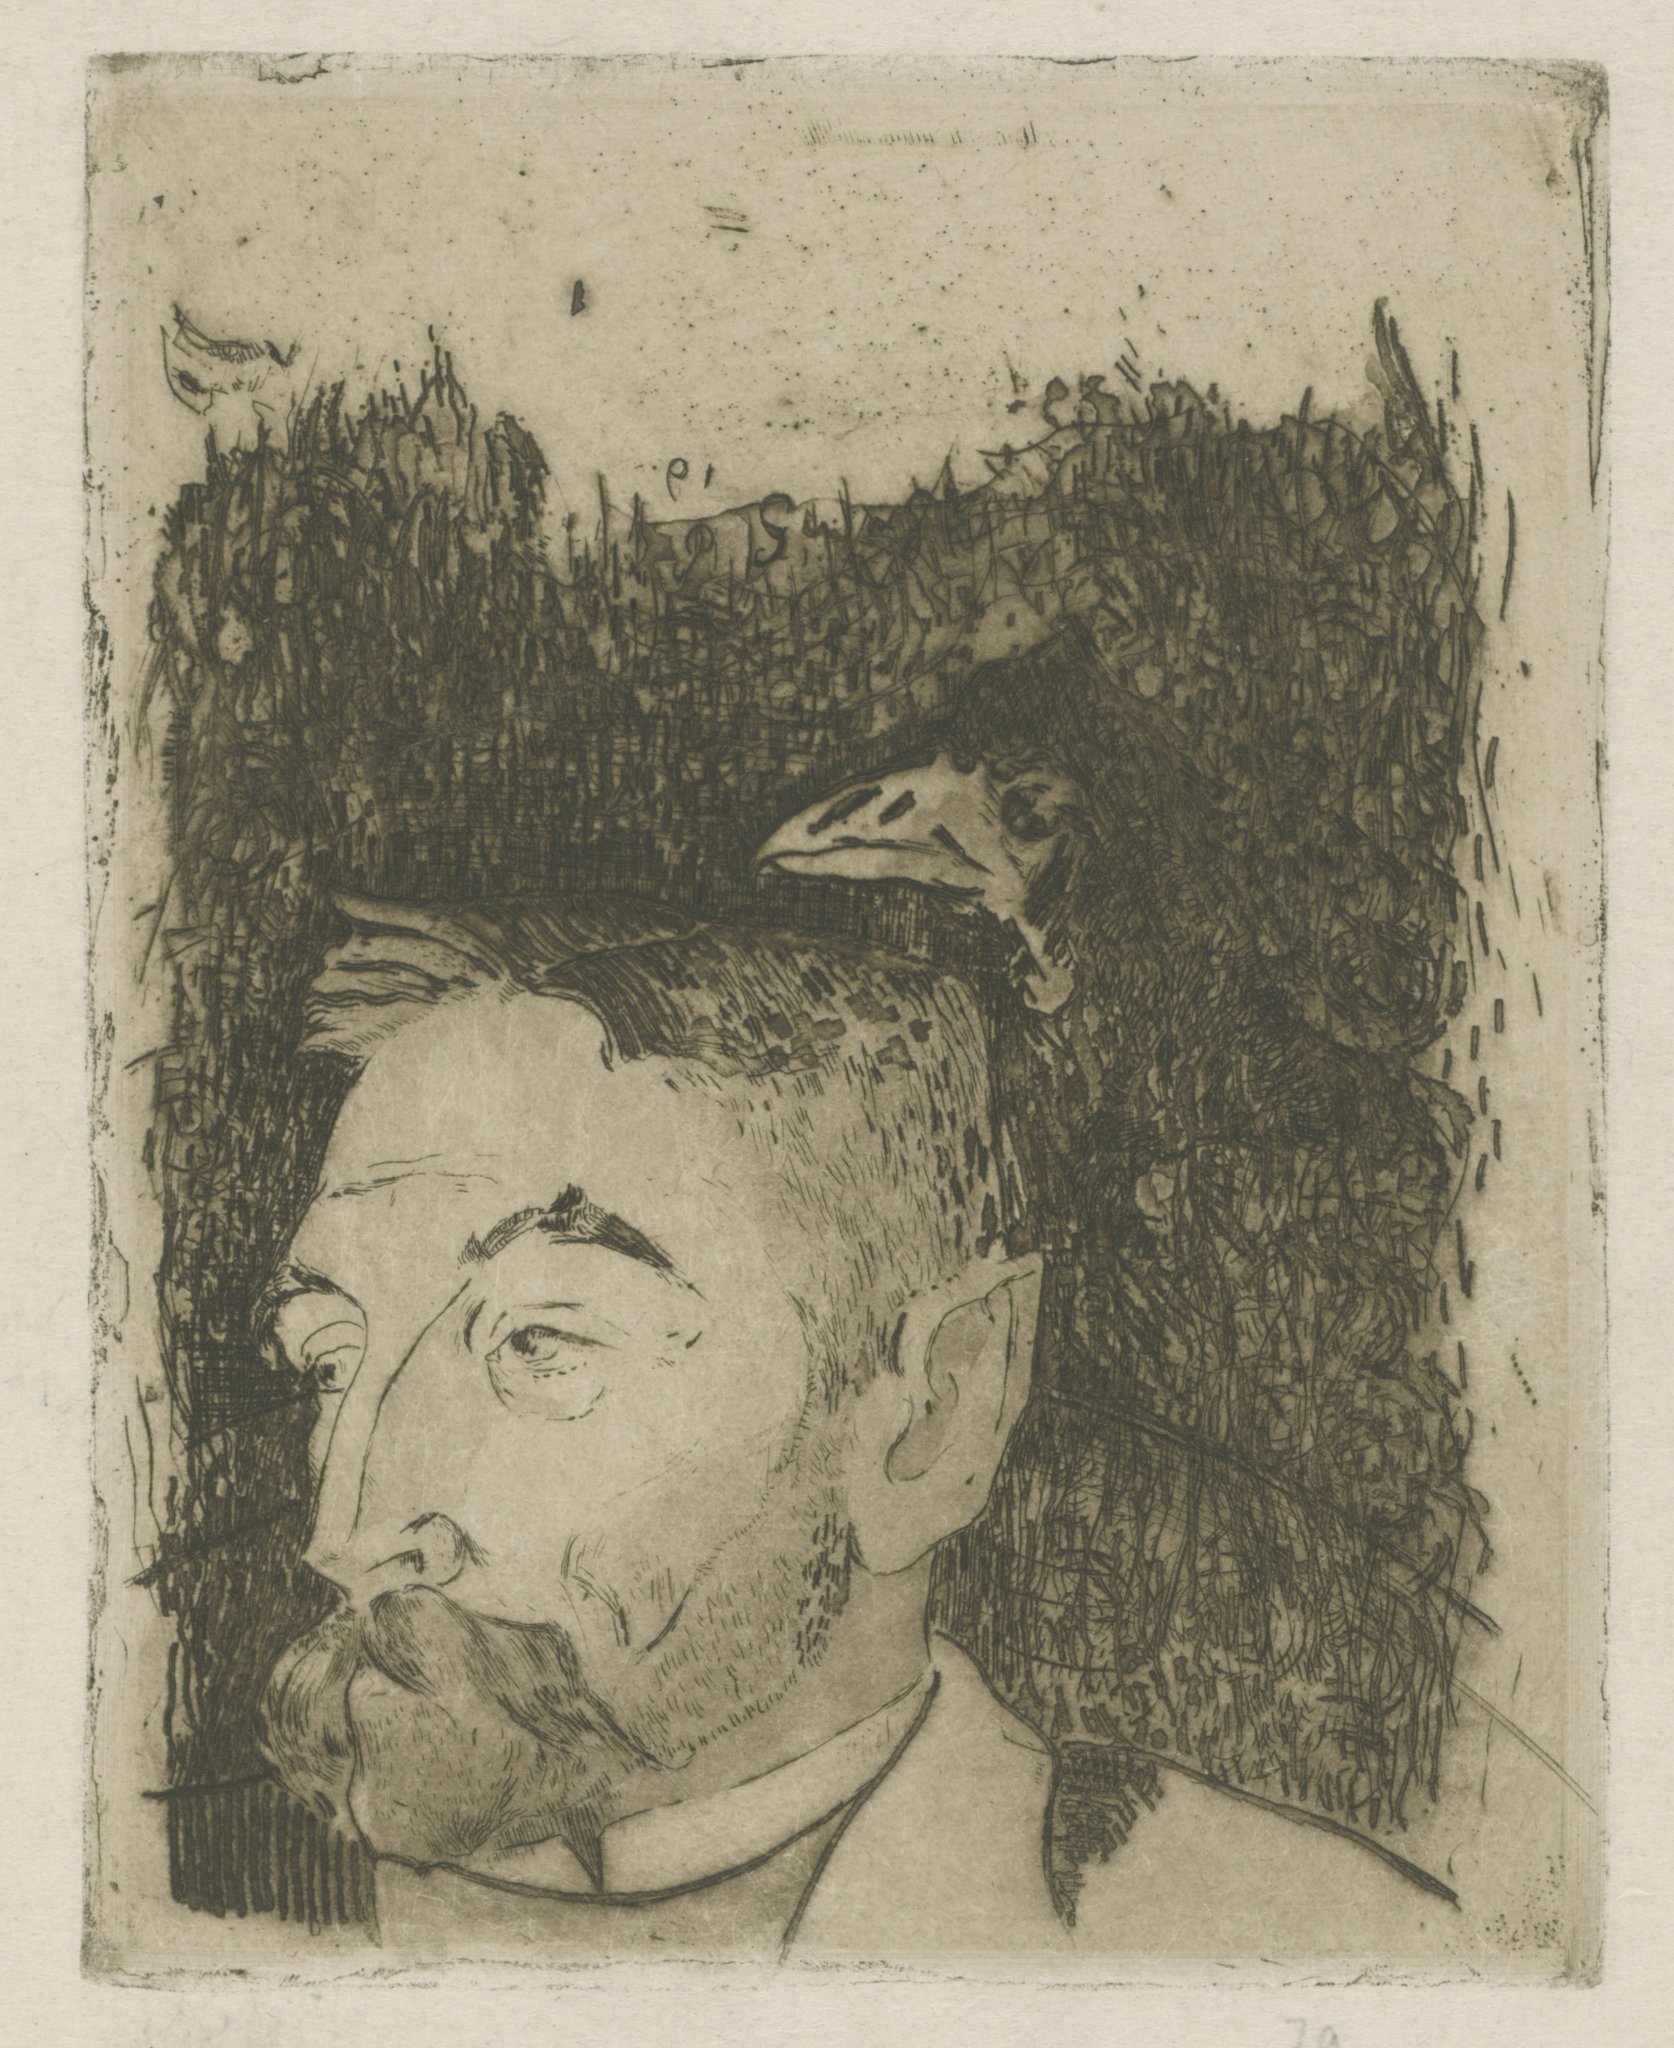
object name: print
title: Portret van Stéphane Mallarmé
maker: paul gauguin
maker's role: draughtsman, print maker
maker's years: 1848-1903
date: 1891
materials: paper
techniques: drypoint, engraving, etching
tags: paris, stéphane mallarmé, historical persons, portrait of a writer, song-birds: raven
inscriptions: collector's mark: Lugt 2228, collector's mark: Lugt 2760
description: Portret van de symbolistische schrijver Stéphane Mallarmé. Achter het portret de kop van een raaf, ontleend aan Manets illustratie van The Raven door Edgar Allan Poe. Mallarmé vertaalde dit gedicht in 1874 in het Frans.